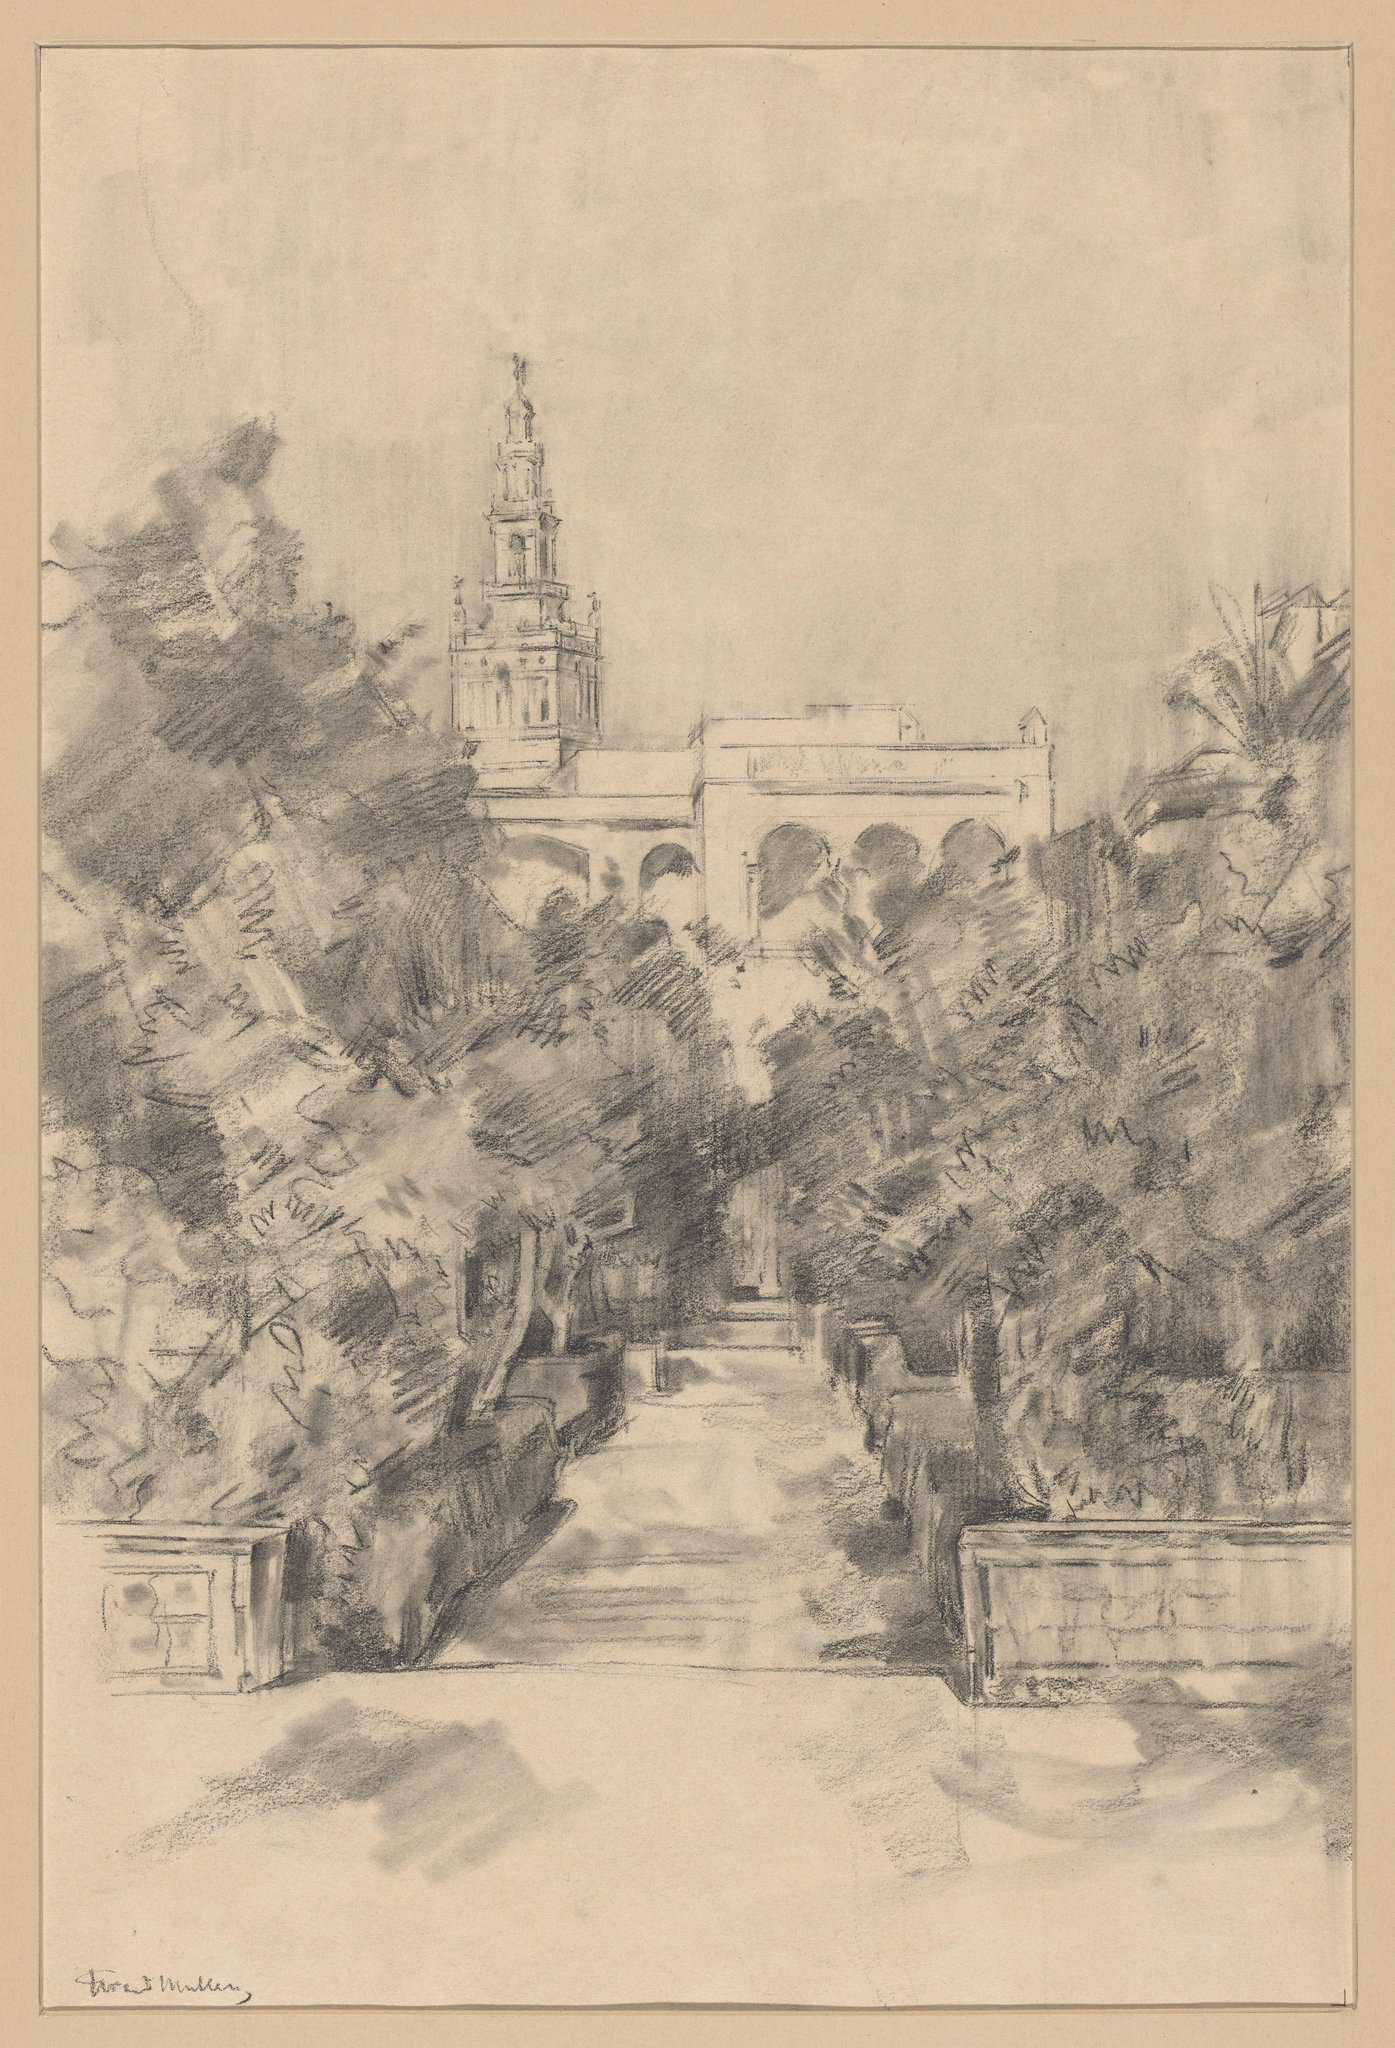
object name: drawing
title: Gezicht op de achterfaçade van het Koninklijk Paleis te Sevilla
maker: gerard muller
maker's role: draughtsman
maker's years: 1861-1929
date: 1871-1903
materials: chalk, paper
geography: sevilla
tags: rear façade, palace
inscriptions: label: ‘13. Alcázar . Sevilla/ Gezicht op de achterfacade’, collector's mark: Lugt 2228